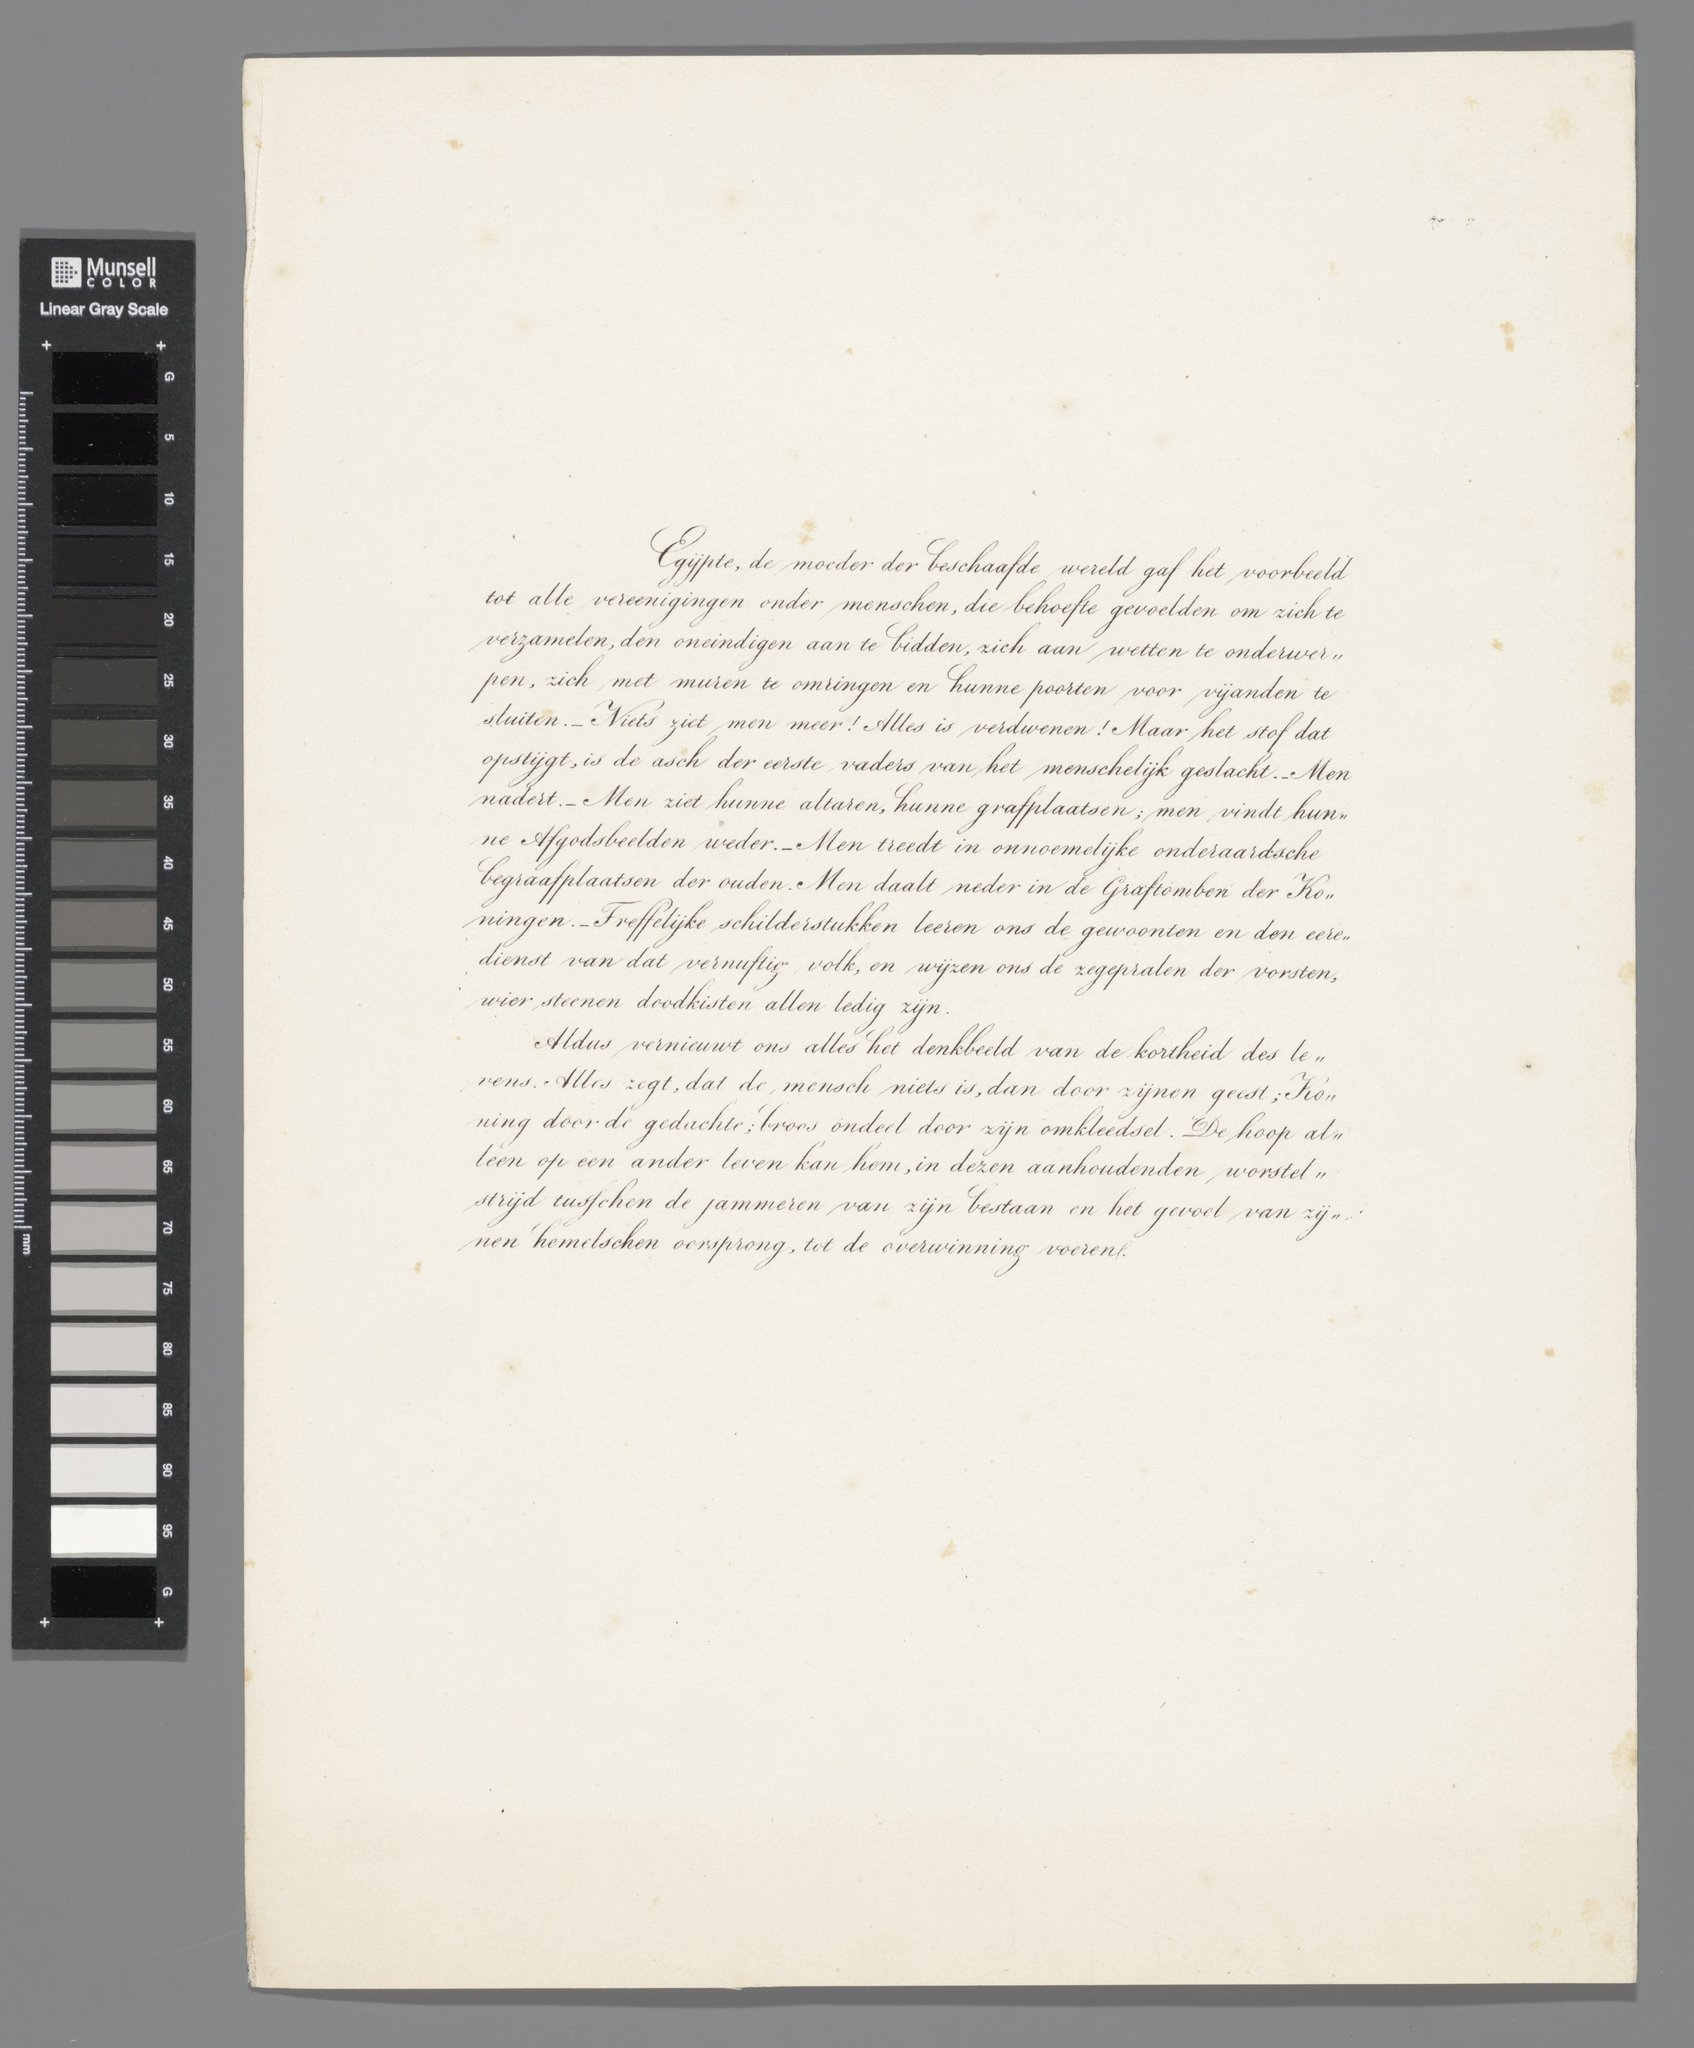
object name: print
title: Egyptische-Gezigten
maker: Anonymous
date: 1830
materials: paper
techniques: lithograph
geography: dordrecht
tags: egypte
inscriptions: collector's mark: Lugt 2228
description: Deze prent maakte deel uit van een serie. De serie bestaat uit vier omslagen, ieder met een inleidende tekst en zes prenten.